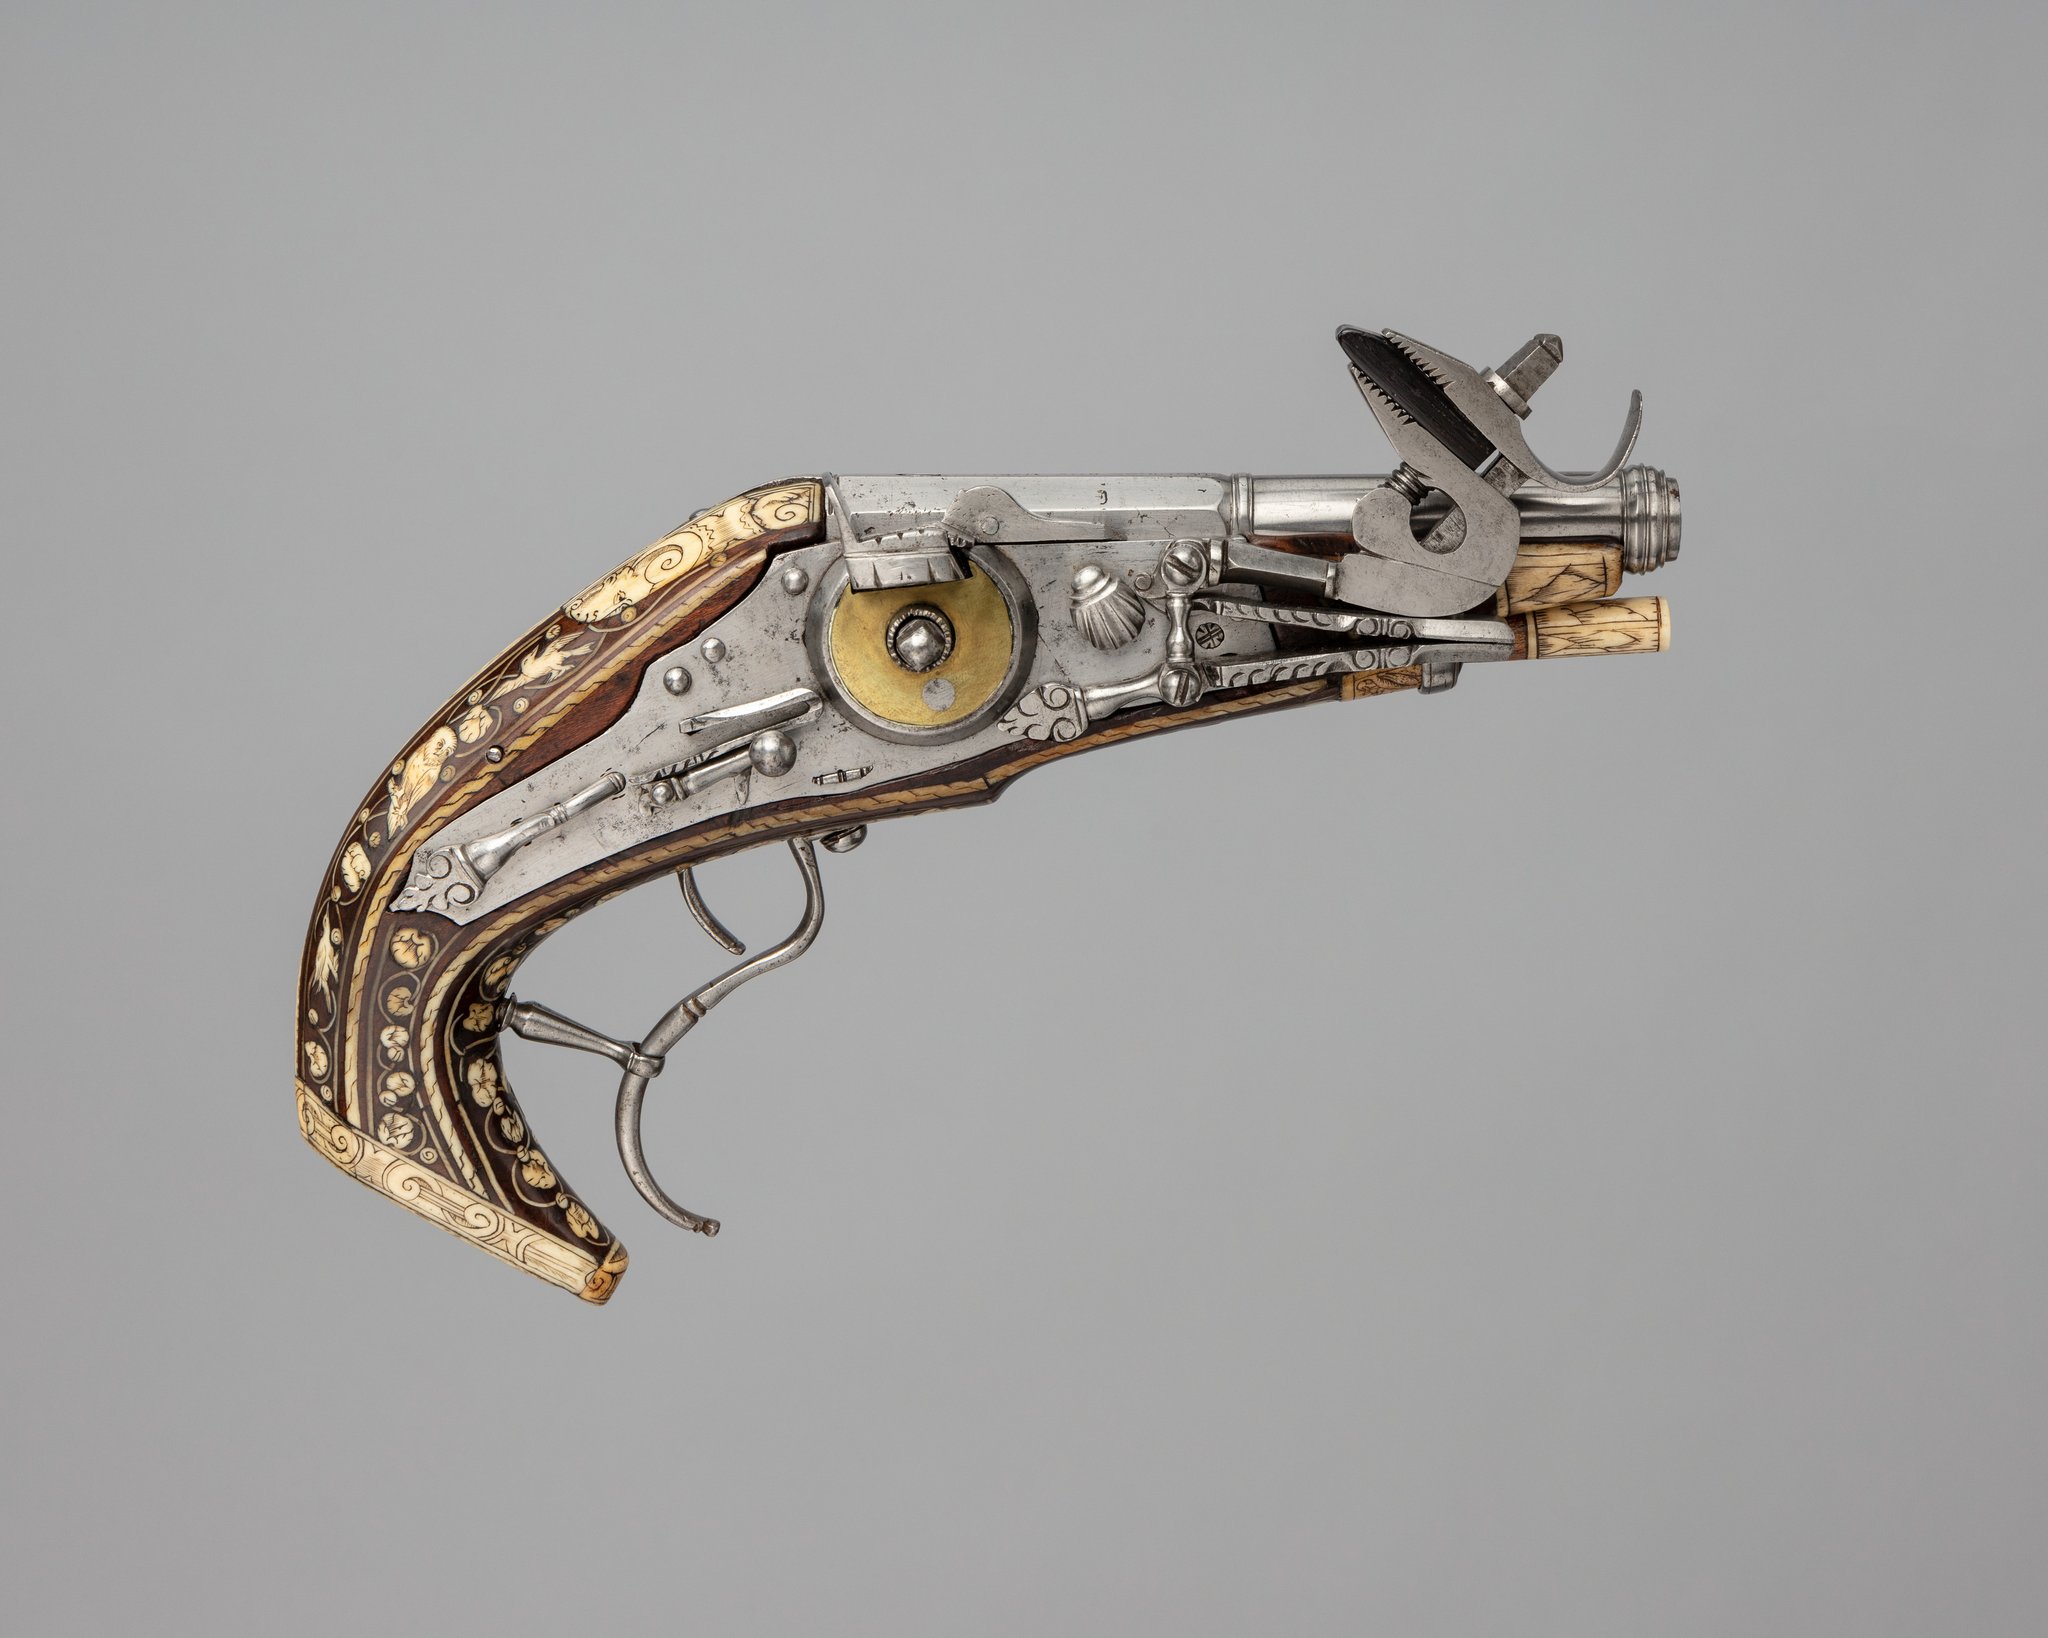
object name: wheellock pistol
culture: swiss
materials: ivory, steel, wood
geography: switzerland